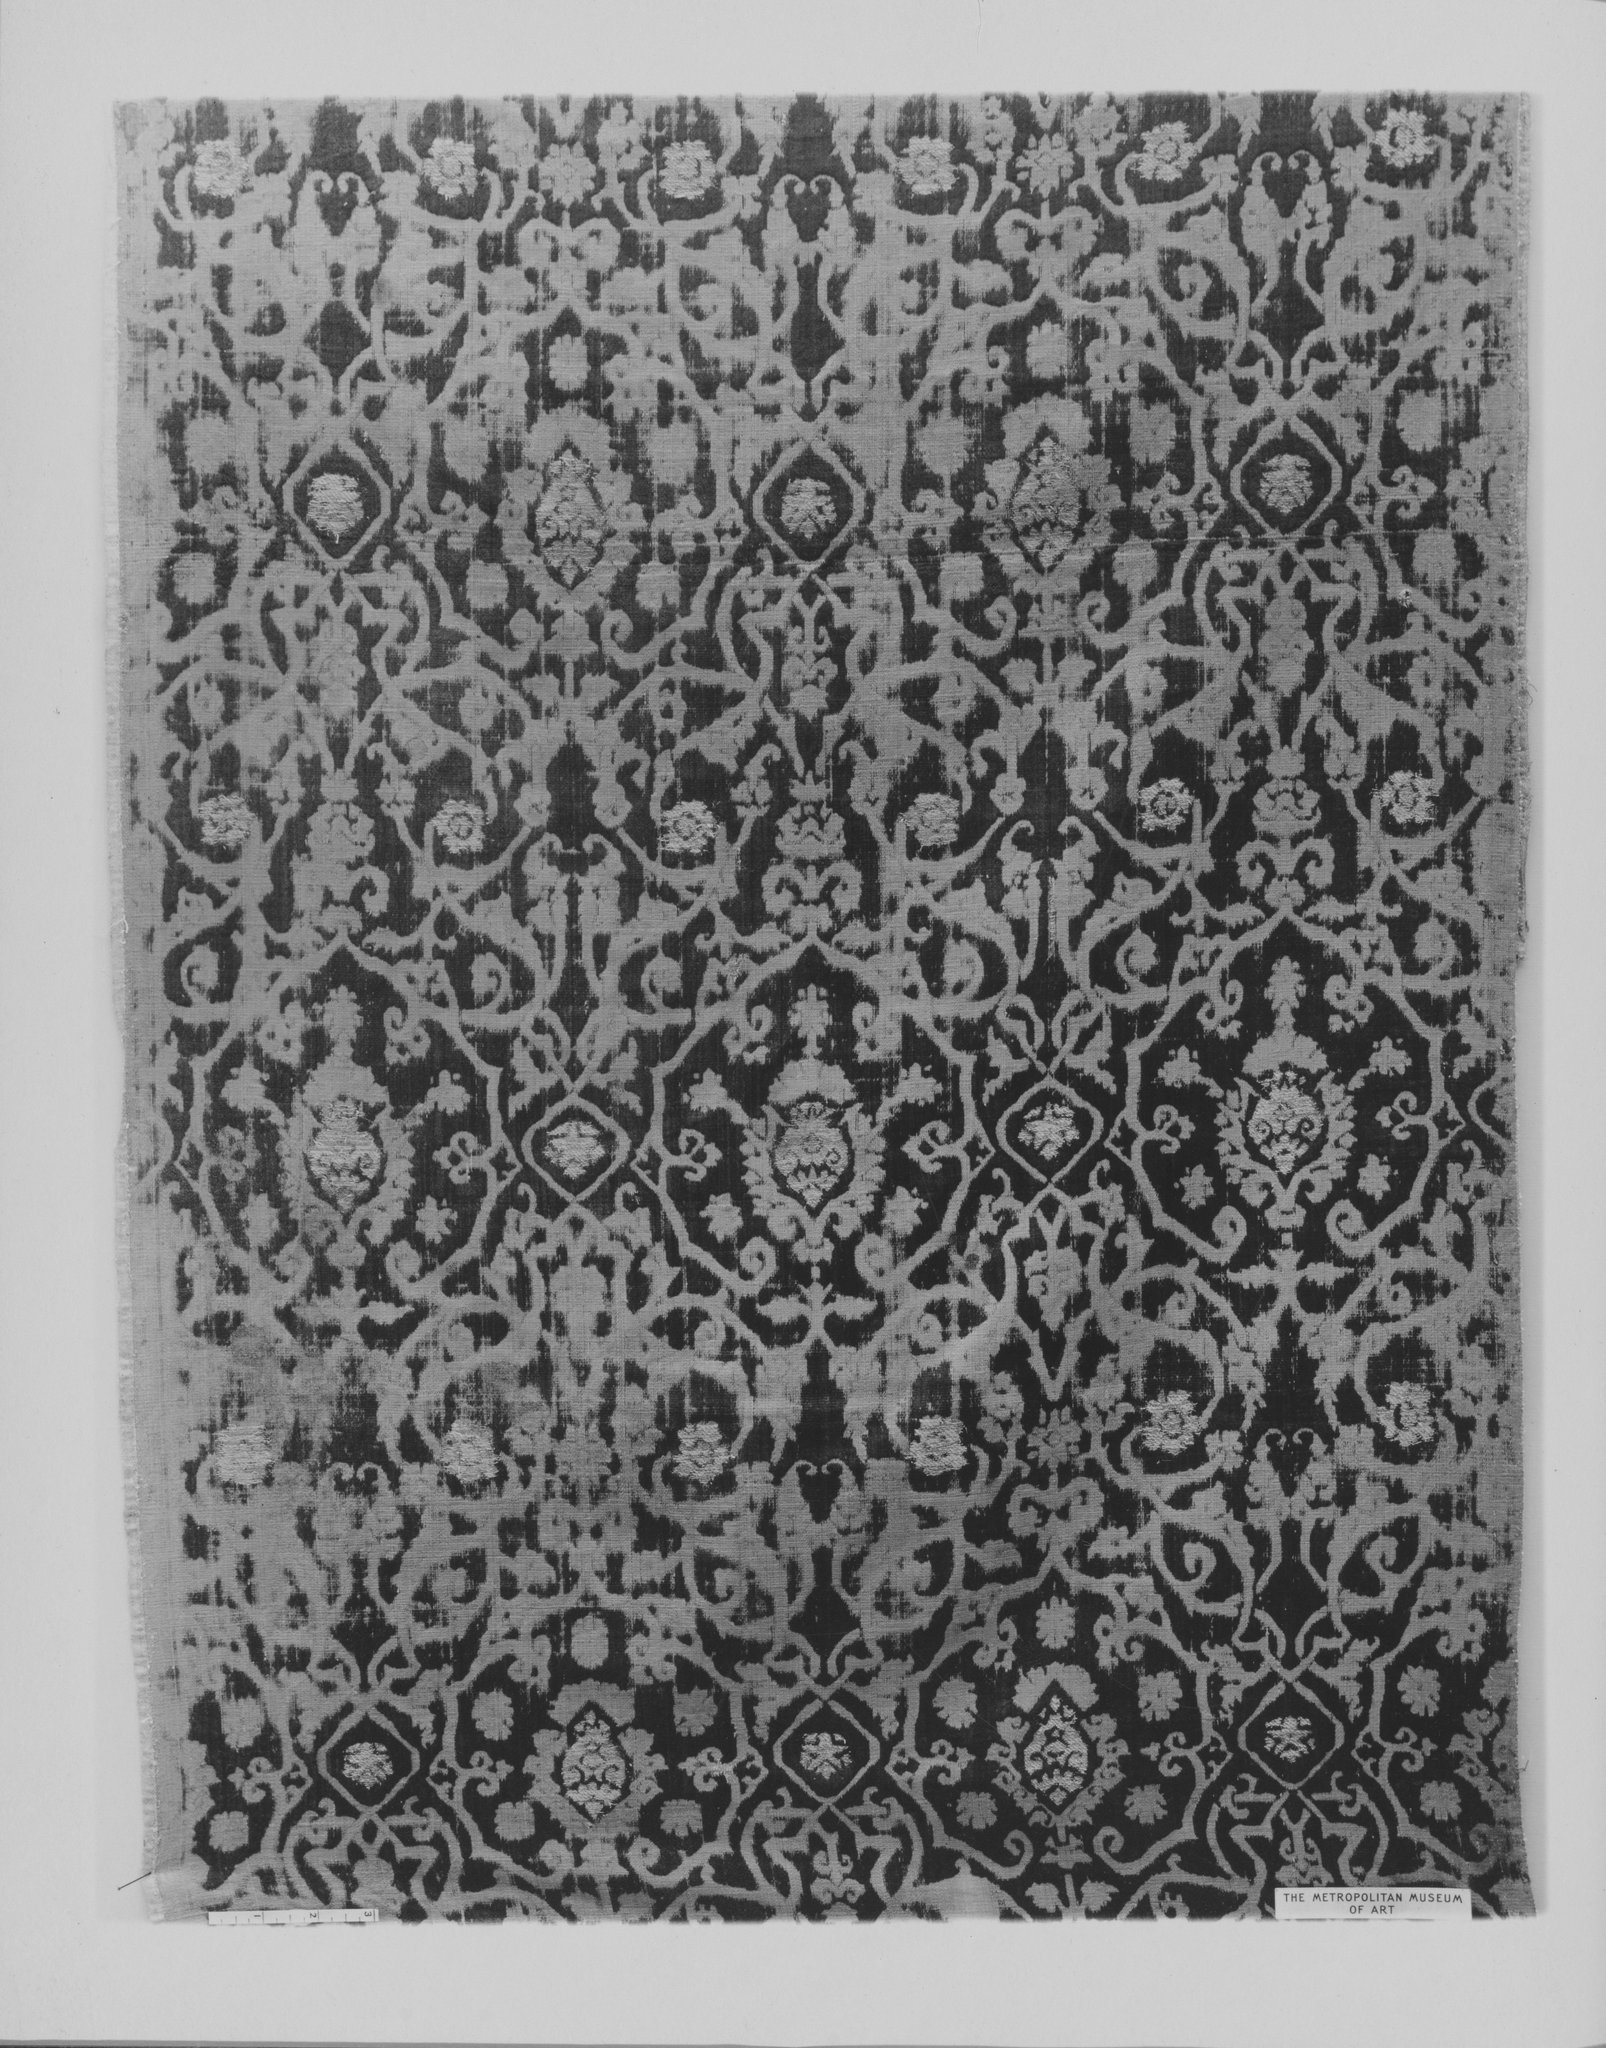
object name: panel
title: Textile Panel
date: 1701-1800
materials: metal thread, silk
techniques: brocade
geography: turkey